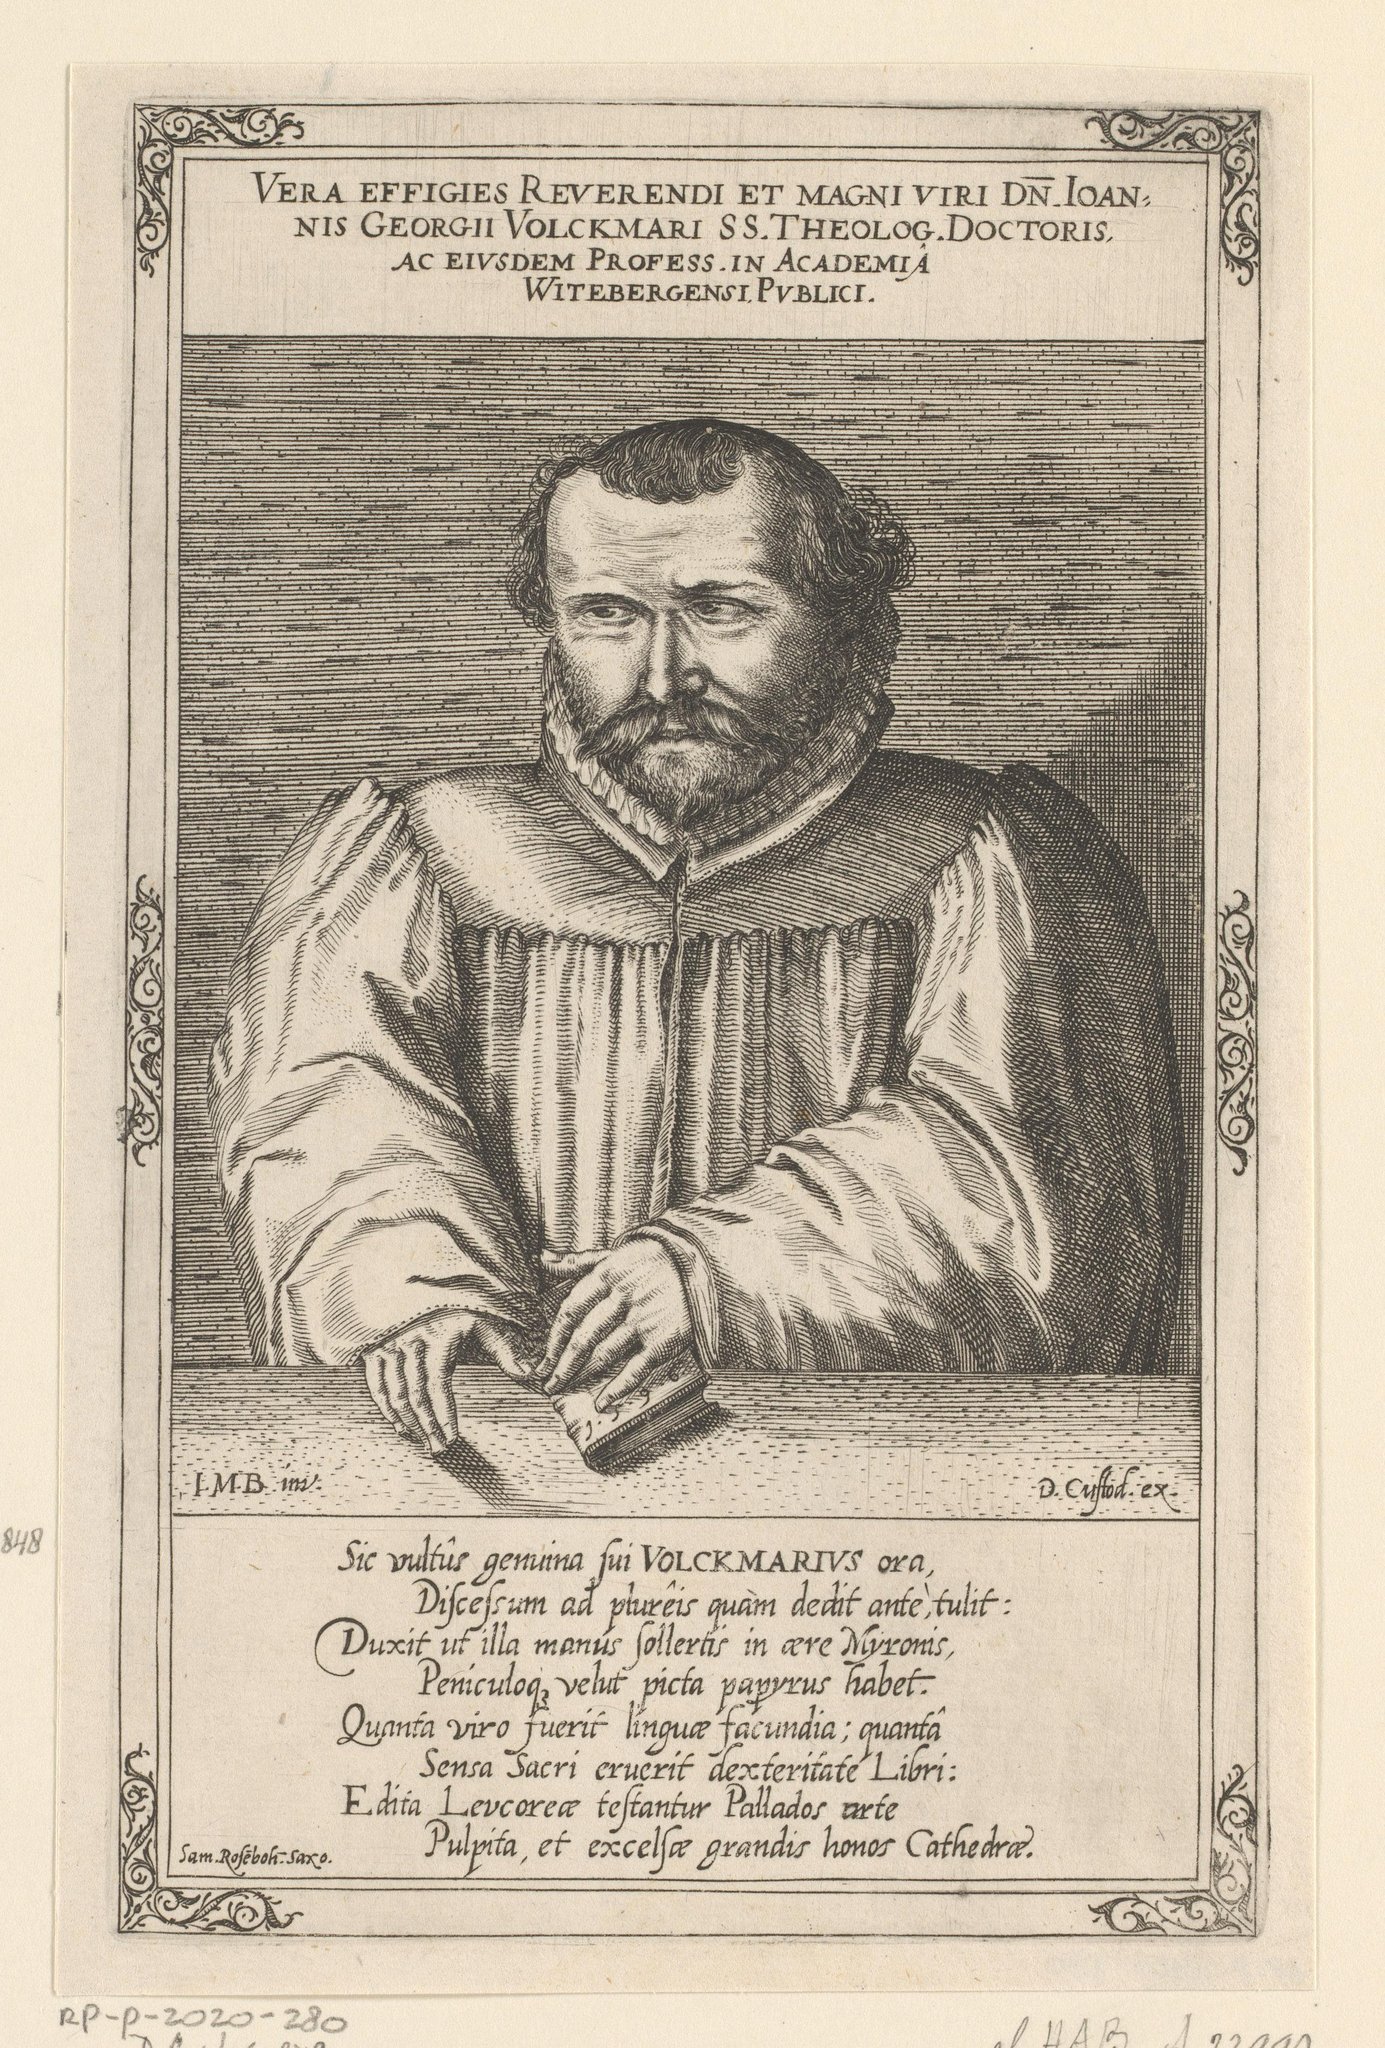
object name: print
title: Portret van Johann Georg Volkmar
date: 1596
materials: paper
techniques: engraving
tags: theologian, historical persons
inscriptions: monogram: ‘I.M.B. inv.’